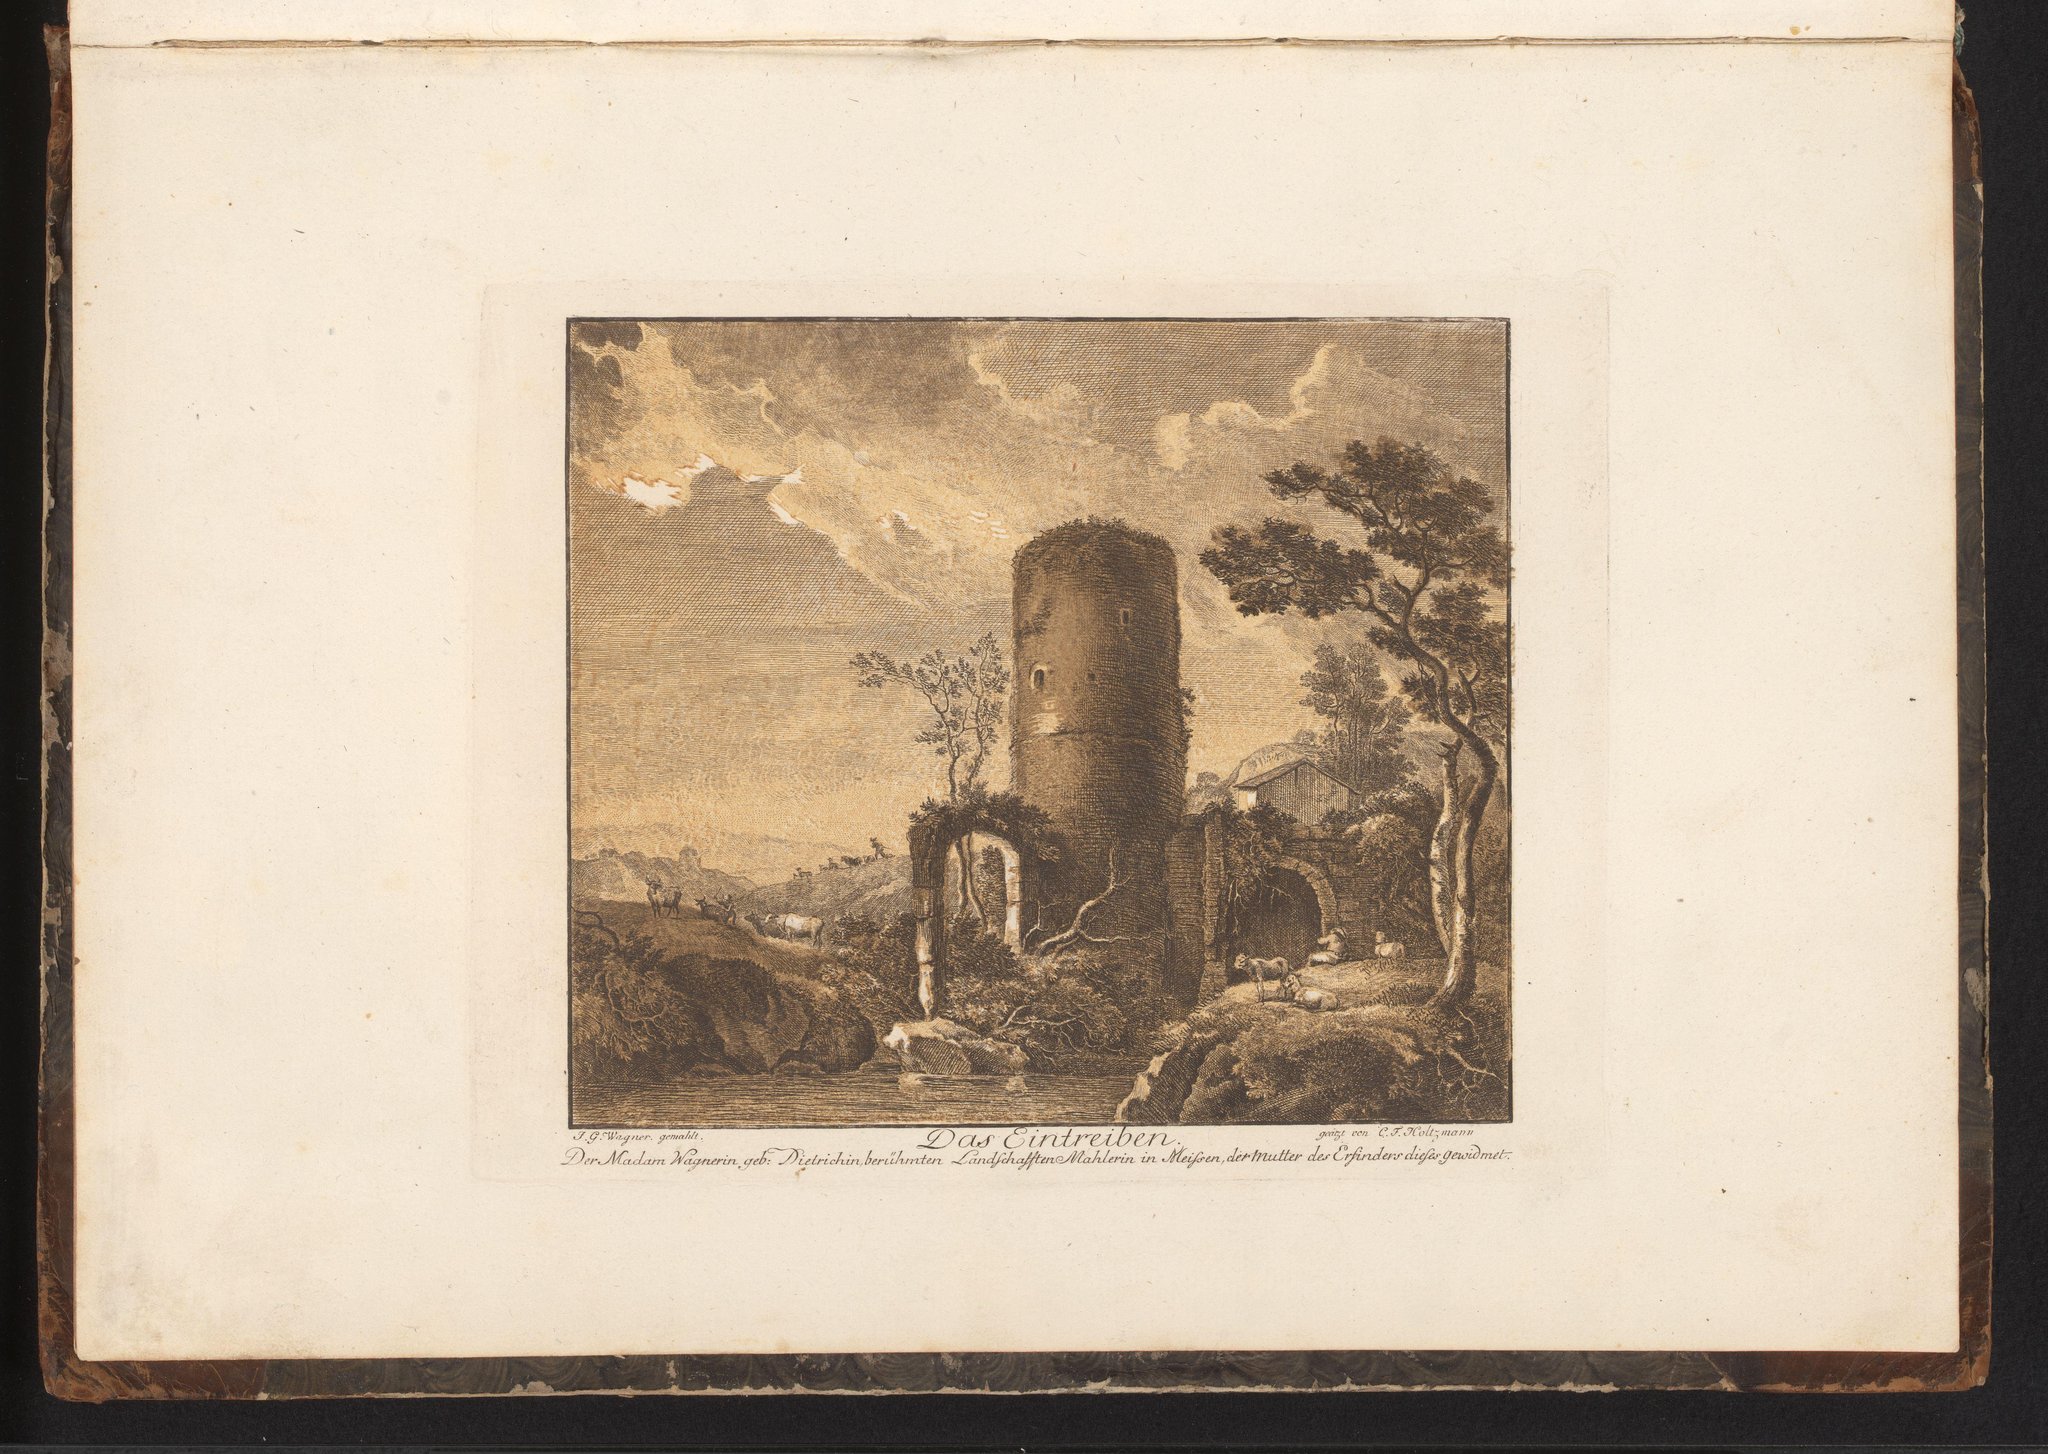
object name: print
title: Das Eintreiben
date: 1750-1811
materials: paper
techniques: etching, intaglio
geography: dresden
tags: herding, herdsman, herdswoman, shepherd, shepherdess, cowherd, etc., cattle, landscape with tower or castle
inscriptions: collector's mark: Lugt 2228, collector's mark: Lugt 2760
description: Tekst in het Duits in de ondermarge. Prent maakt deel uit van een album.